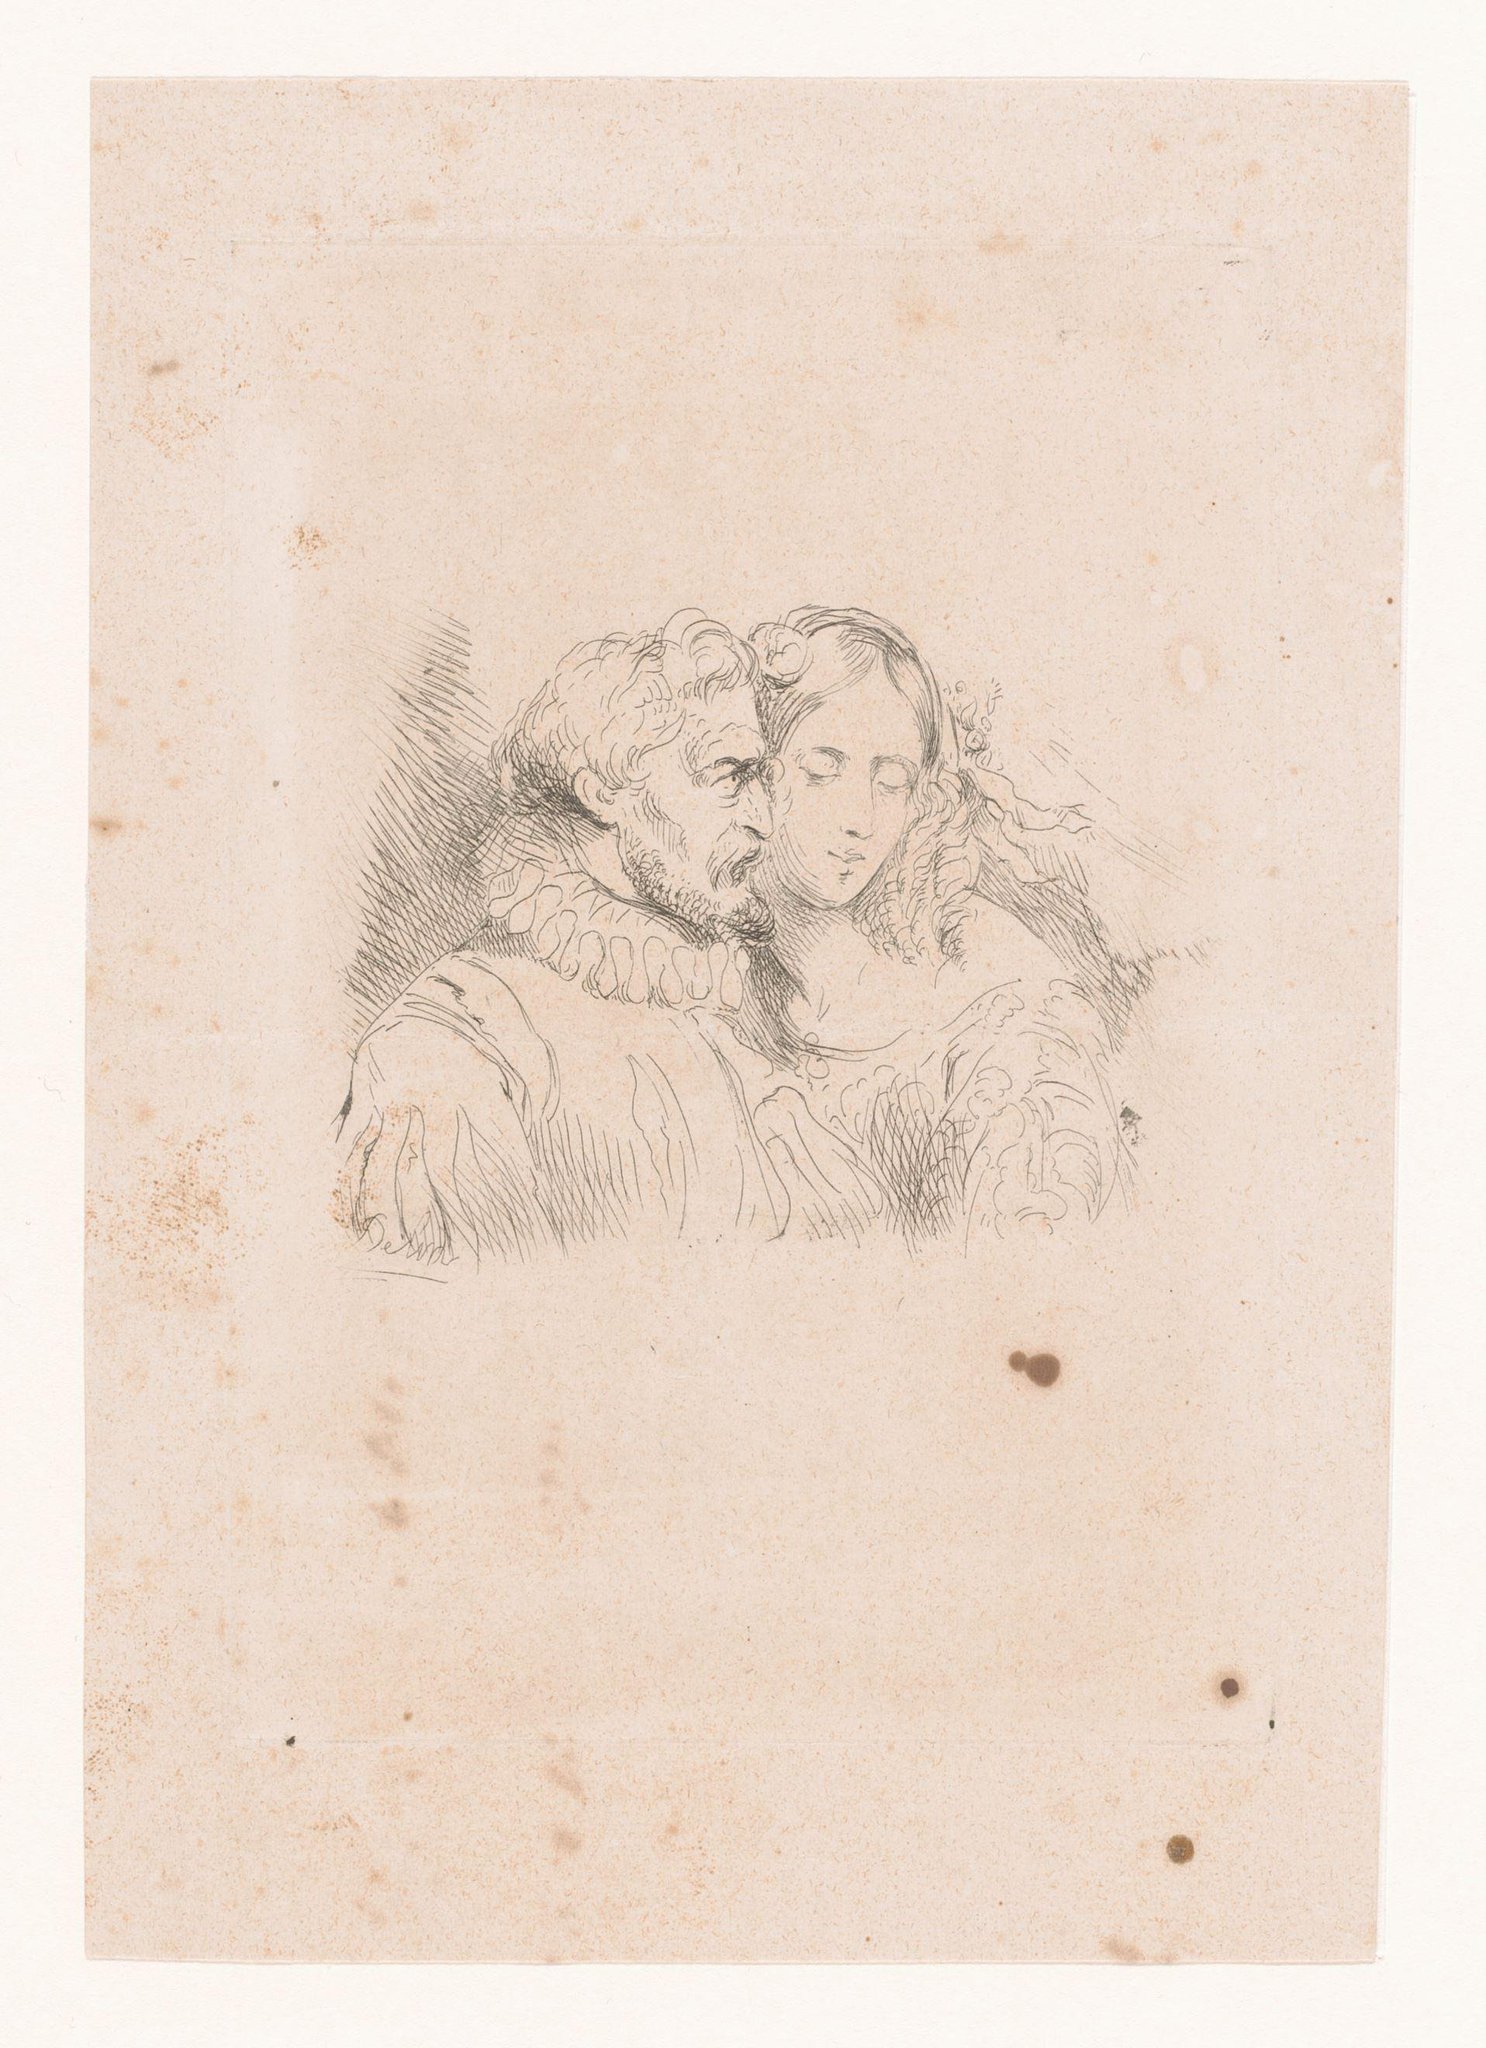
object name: print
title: Borstbeeld van een man en vrouw in zestiende-eeuwse kleding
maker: joseph delin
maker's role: painter, print maker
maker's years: 1821-1892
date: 1831-1877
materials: paper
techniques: etching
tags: anonymous historical persons portrayed in a double portrait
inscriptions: collector's mark: Lugt 2228